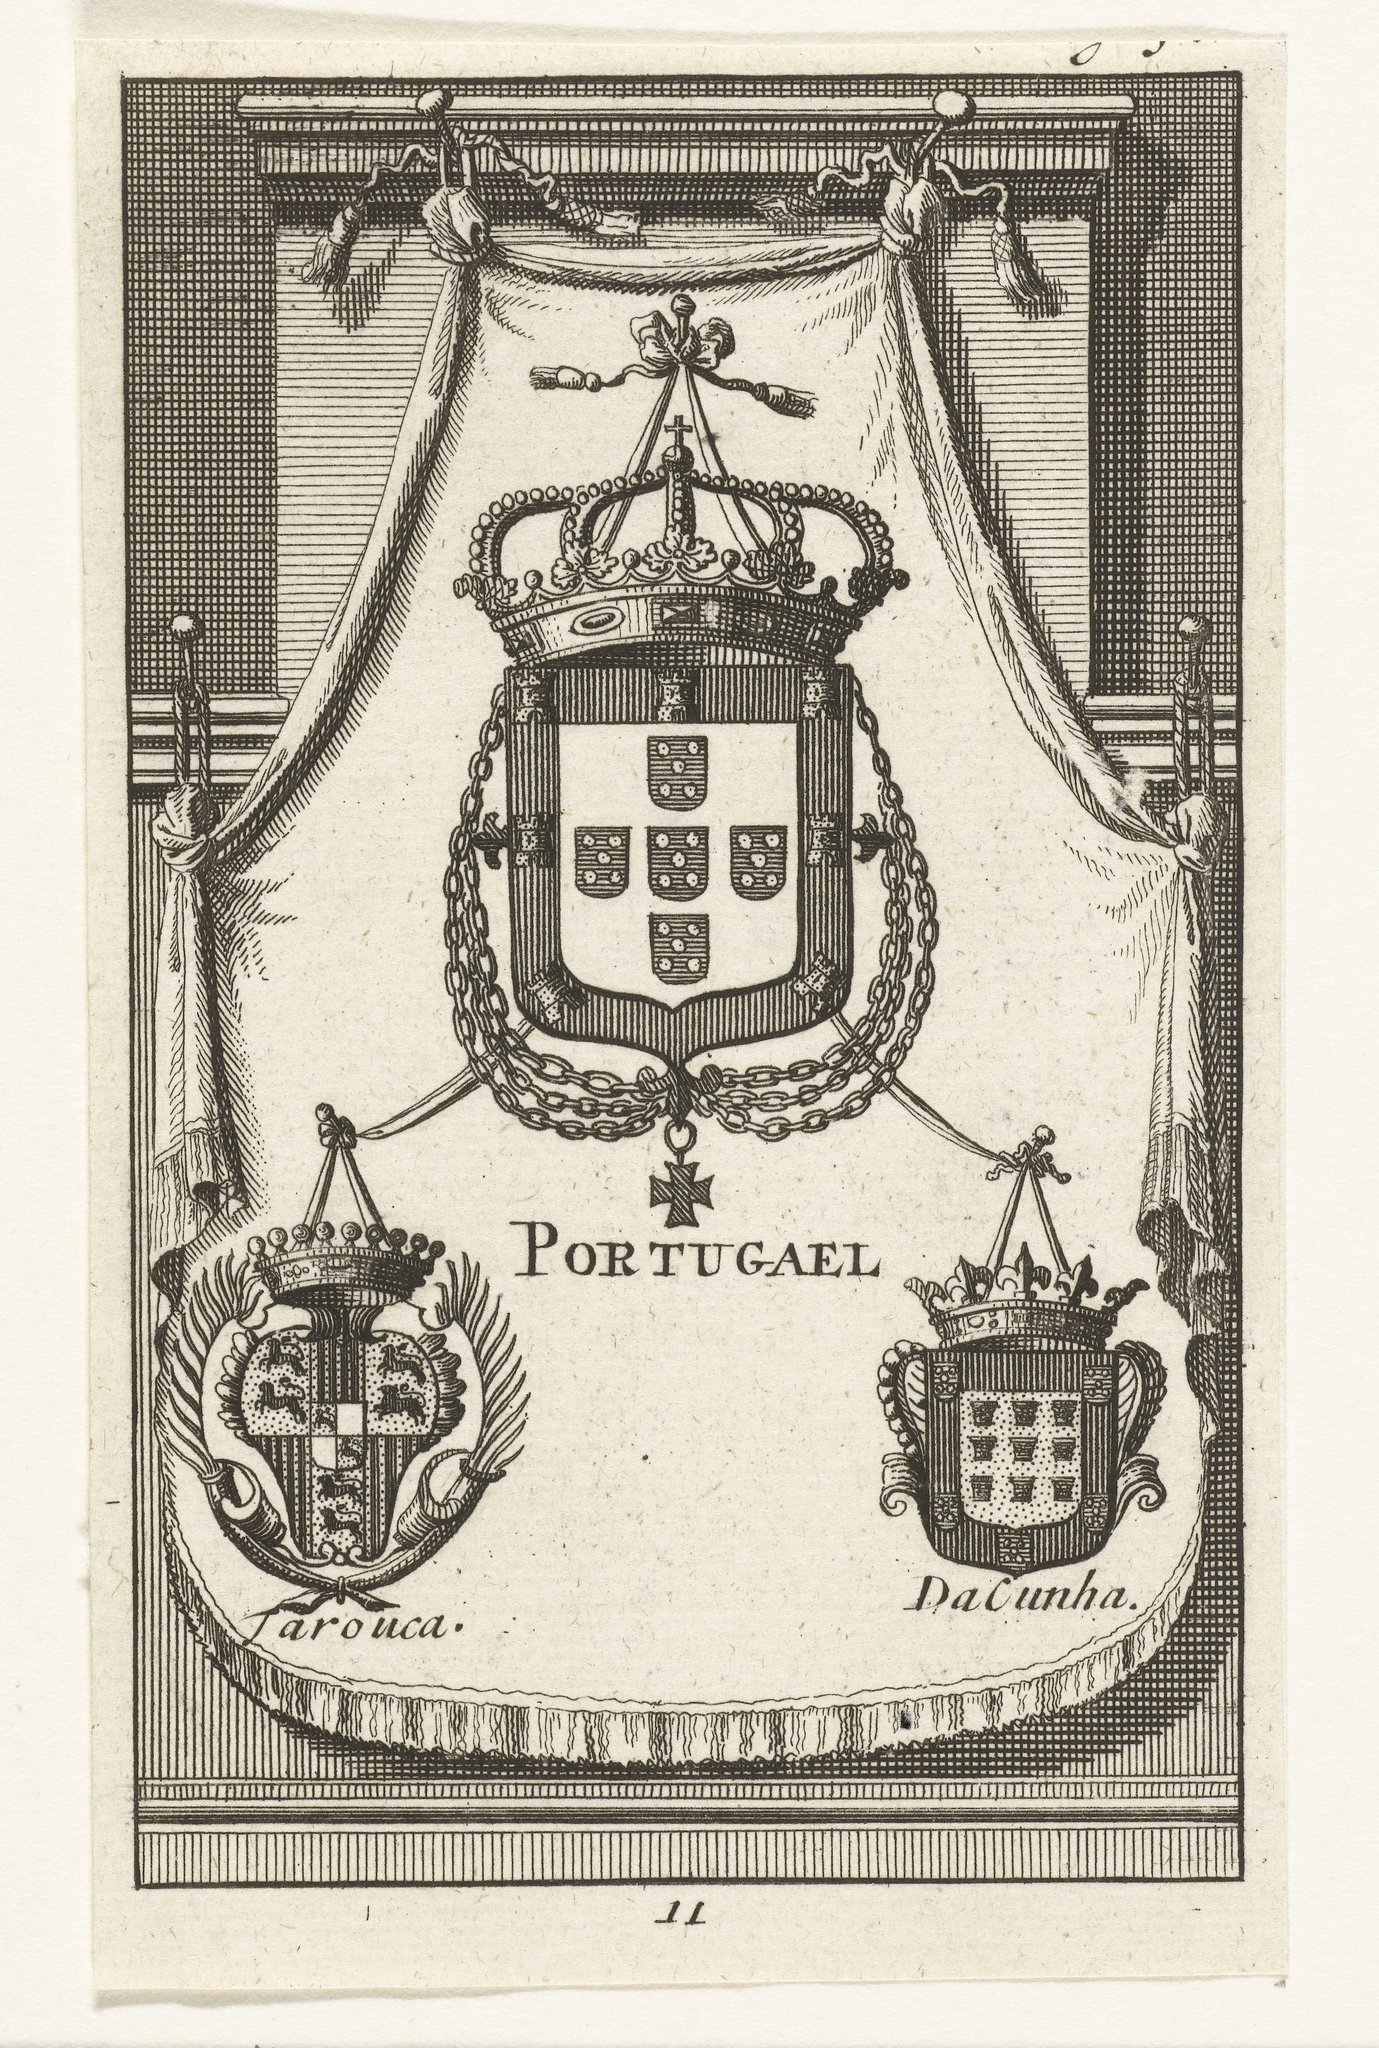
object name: print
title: Wapens van de gevolmachtigden van Portugal bij de vredesonderhandelingen te Utrecht (nr. 11), 1712-1713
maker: Anonymous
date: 1713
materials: paper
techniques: etching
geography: northern netherlands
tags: weapons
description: Gebruikt als illustratie in: Nicolaas Chevalier, Lyste der namen ende qualiteiten van (...) de heeren plenipotentiarissen envoyees (...) op het congres, over de generale vrede, t'Utrecht, N. Chevalier, Utrecht 1713.